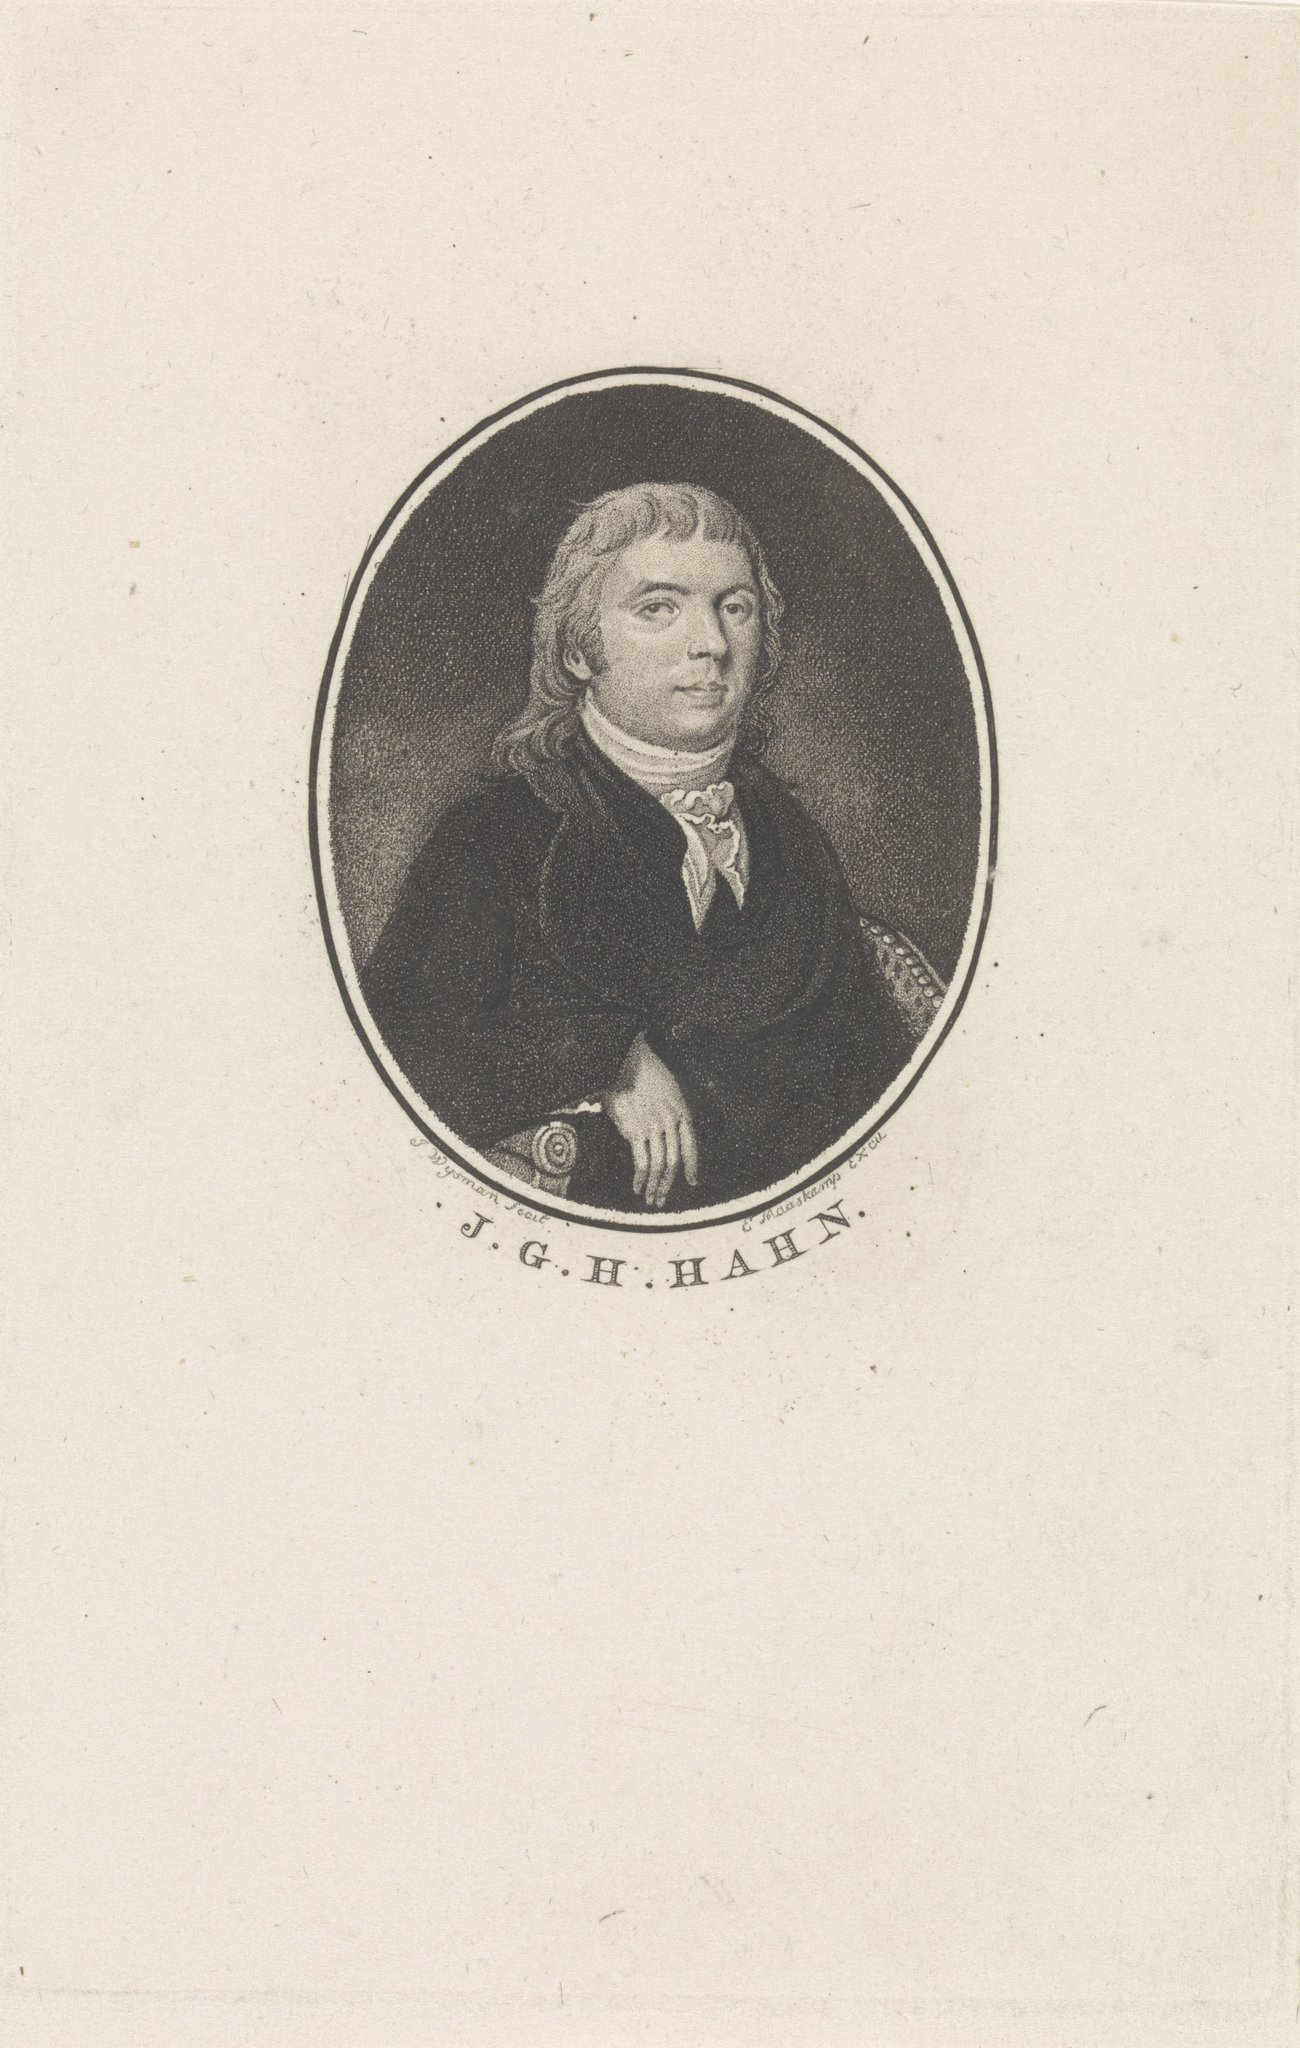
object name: print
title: Portret van Jacob George Jeronimo Hahn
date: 1796-1798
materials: paper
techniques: etching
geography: amsterdam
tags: utrecht, haarlem, politician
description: Portret van Jacob George Jeronimo Hahn, representant in de Nationale Vergadering van 1796 en 1797.